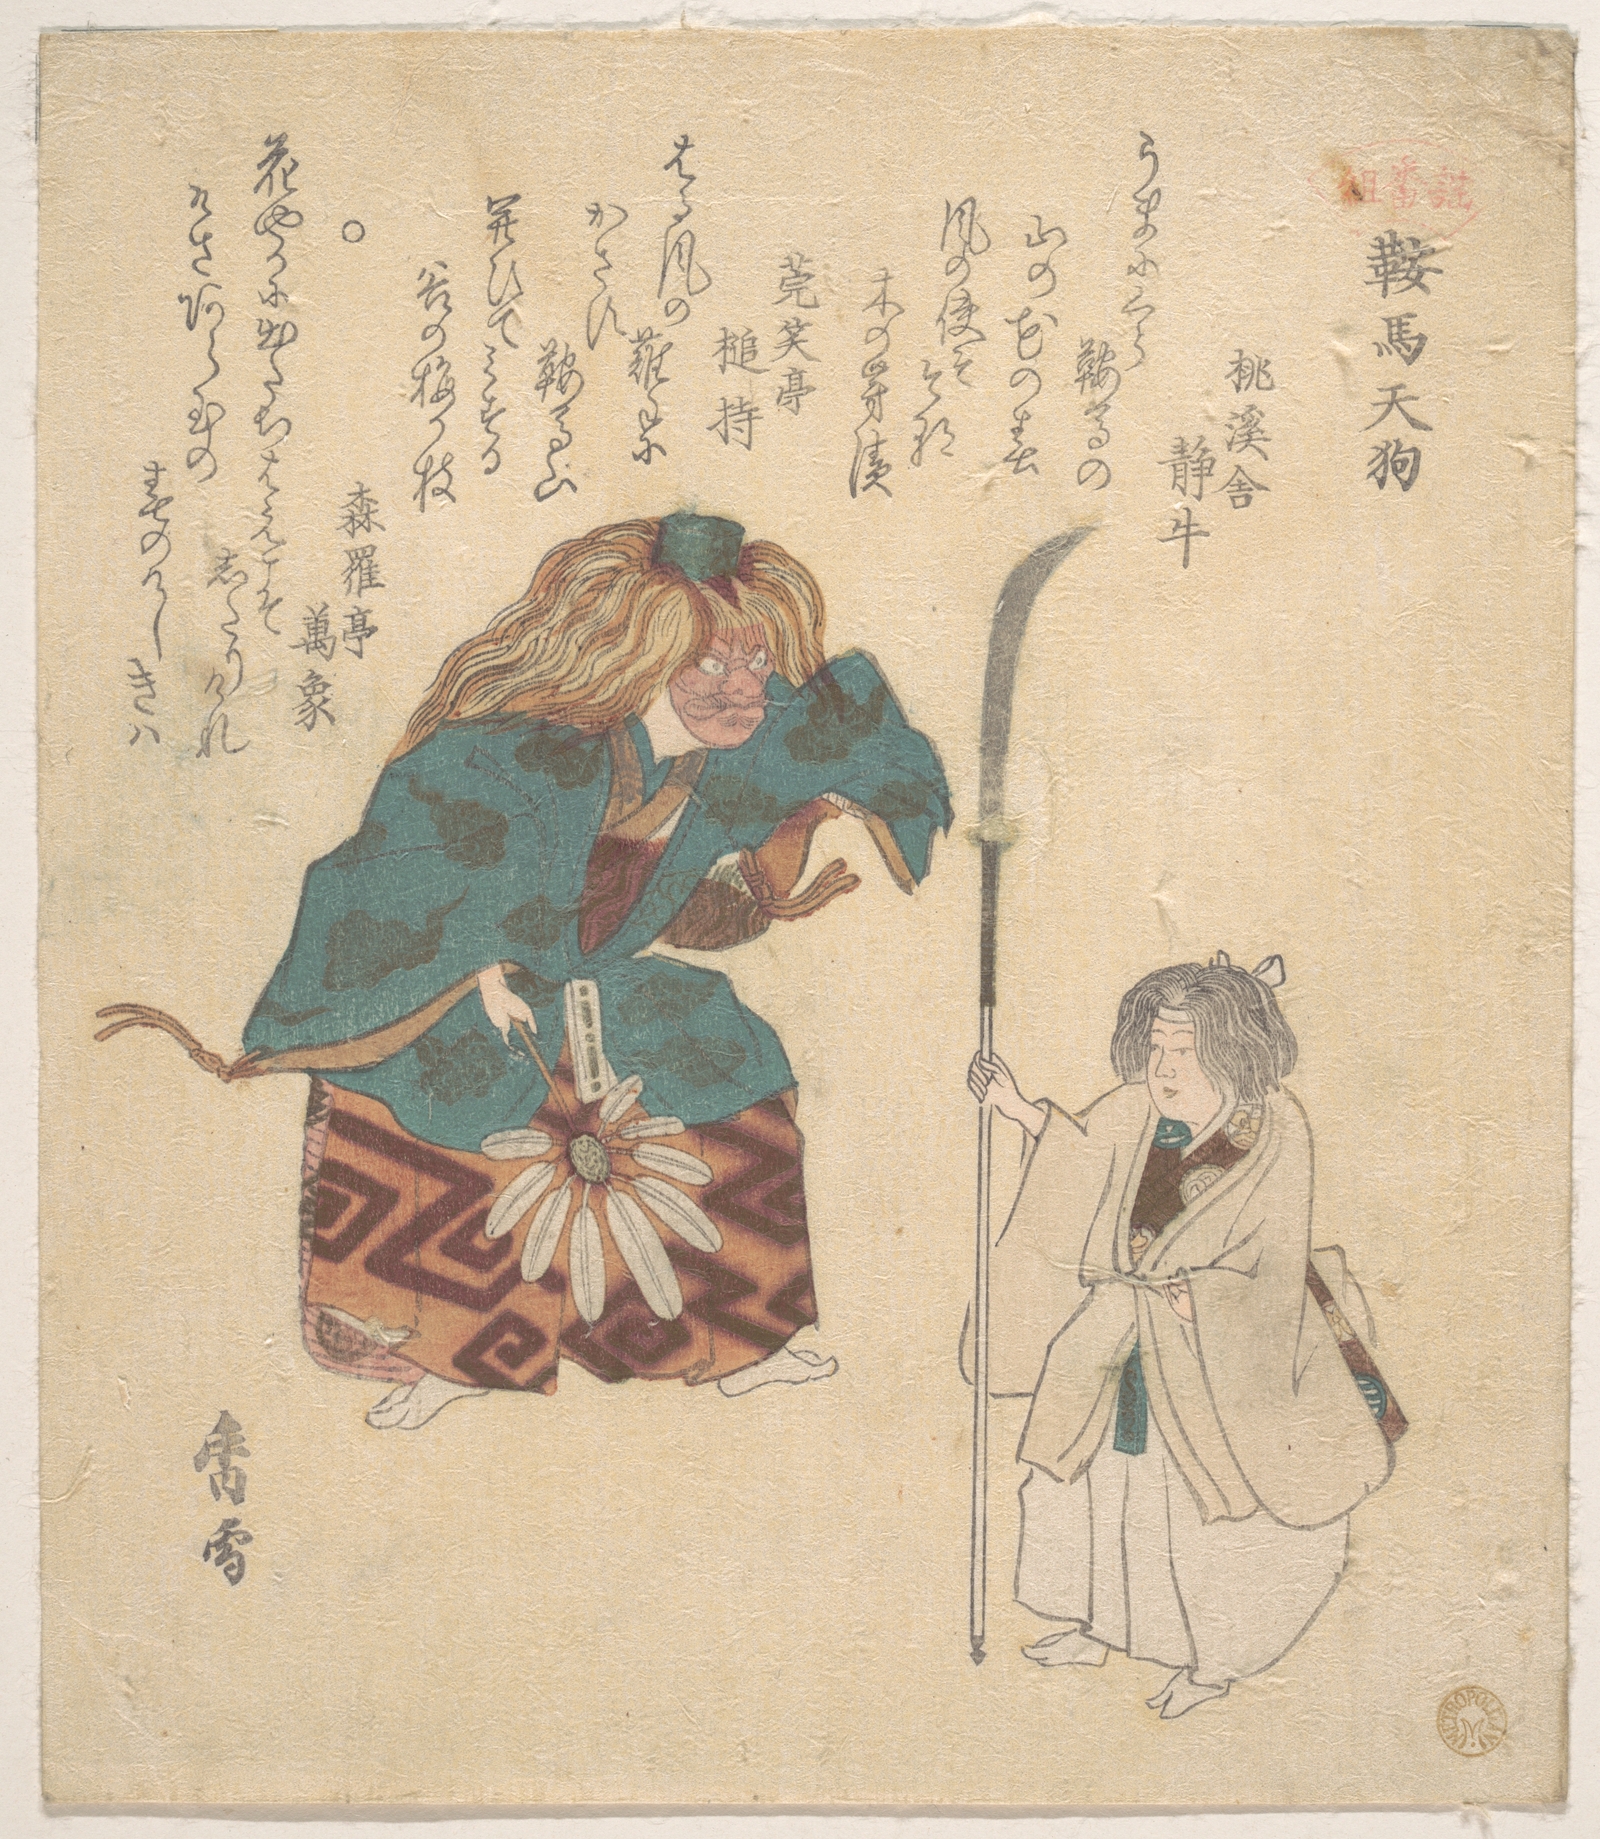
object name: print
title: Scene from Noh Dance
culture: japanese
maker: kosetsu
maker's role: artist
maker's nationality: japanese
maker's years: 1800-1899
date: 1820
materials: ink, paper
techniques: surimono, woodblock print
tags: weapons,women